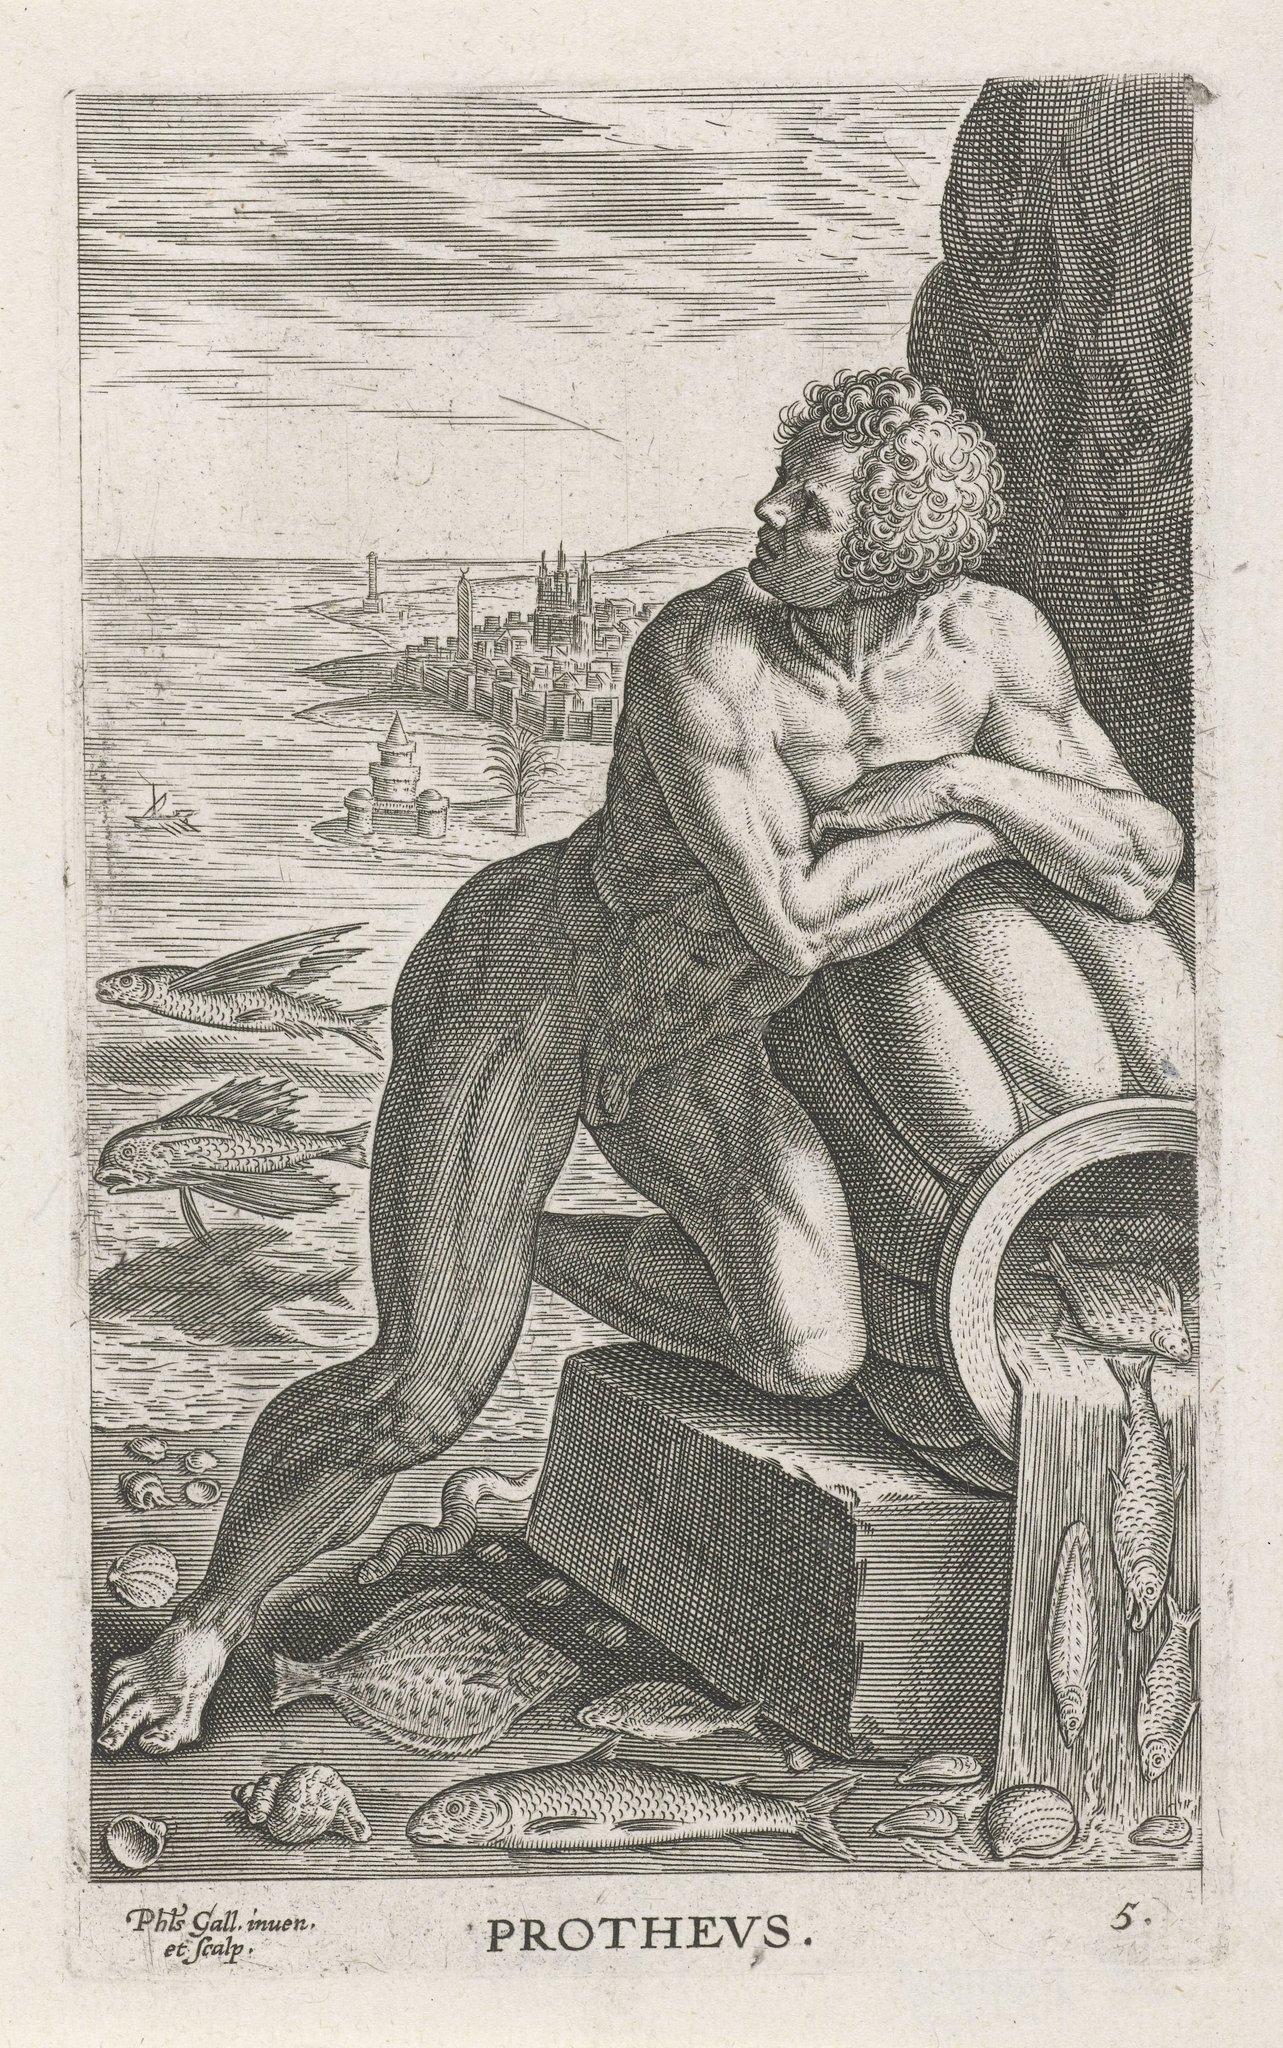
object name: print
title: Zeegod Protheus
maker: philips galle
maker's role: print maker, publisher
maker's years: 1537-1612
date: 1586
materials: paper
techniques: engraving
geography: antwerp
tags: proteus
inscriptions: collector's mark: Lugt 2228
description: De zeegod Protheus, leunend tegen een waterkruik waar vissen uit stromen. In de achtergrond een havenstad. De prent maakt deel uit van een zeventiendelige serie over rivier- en zeegoden.